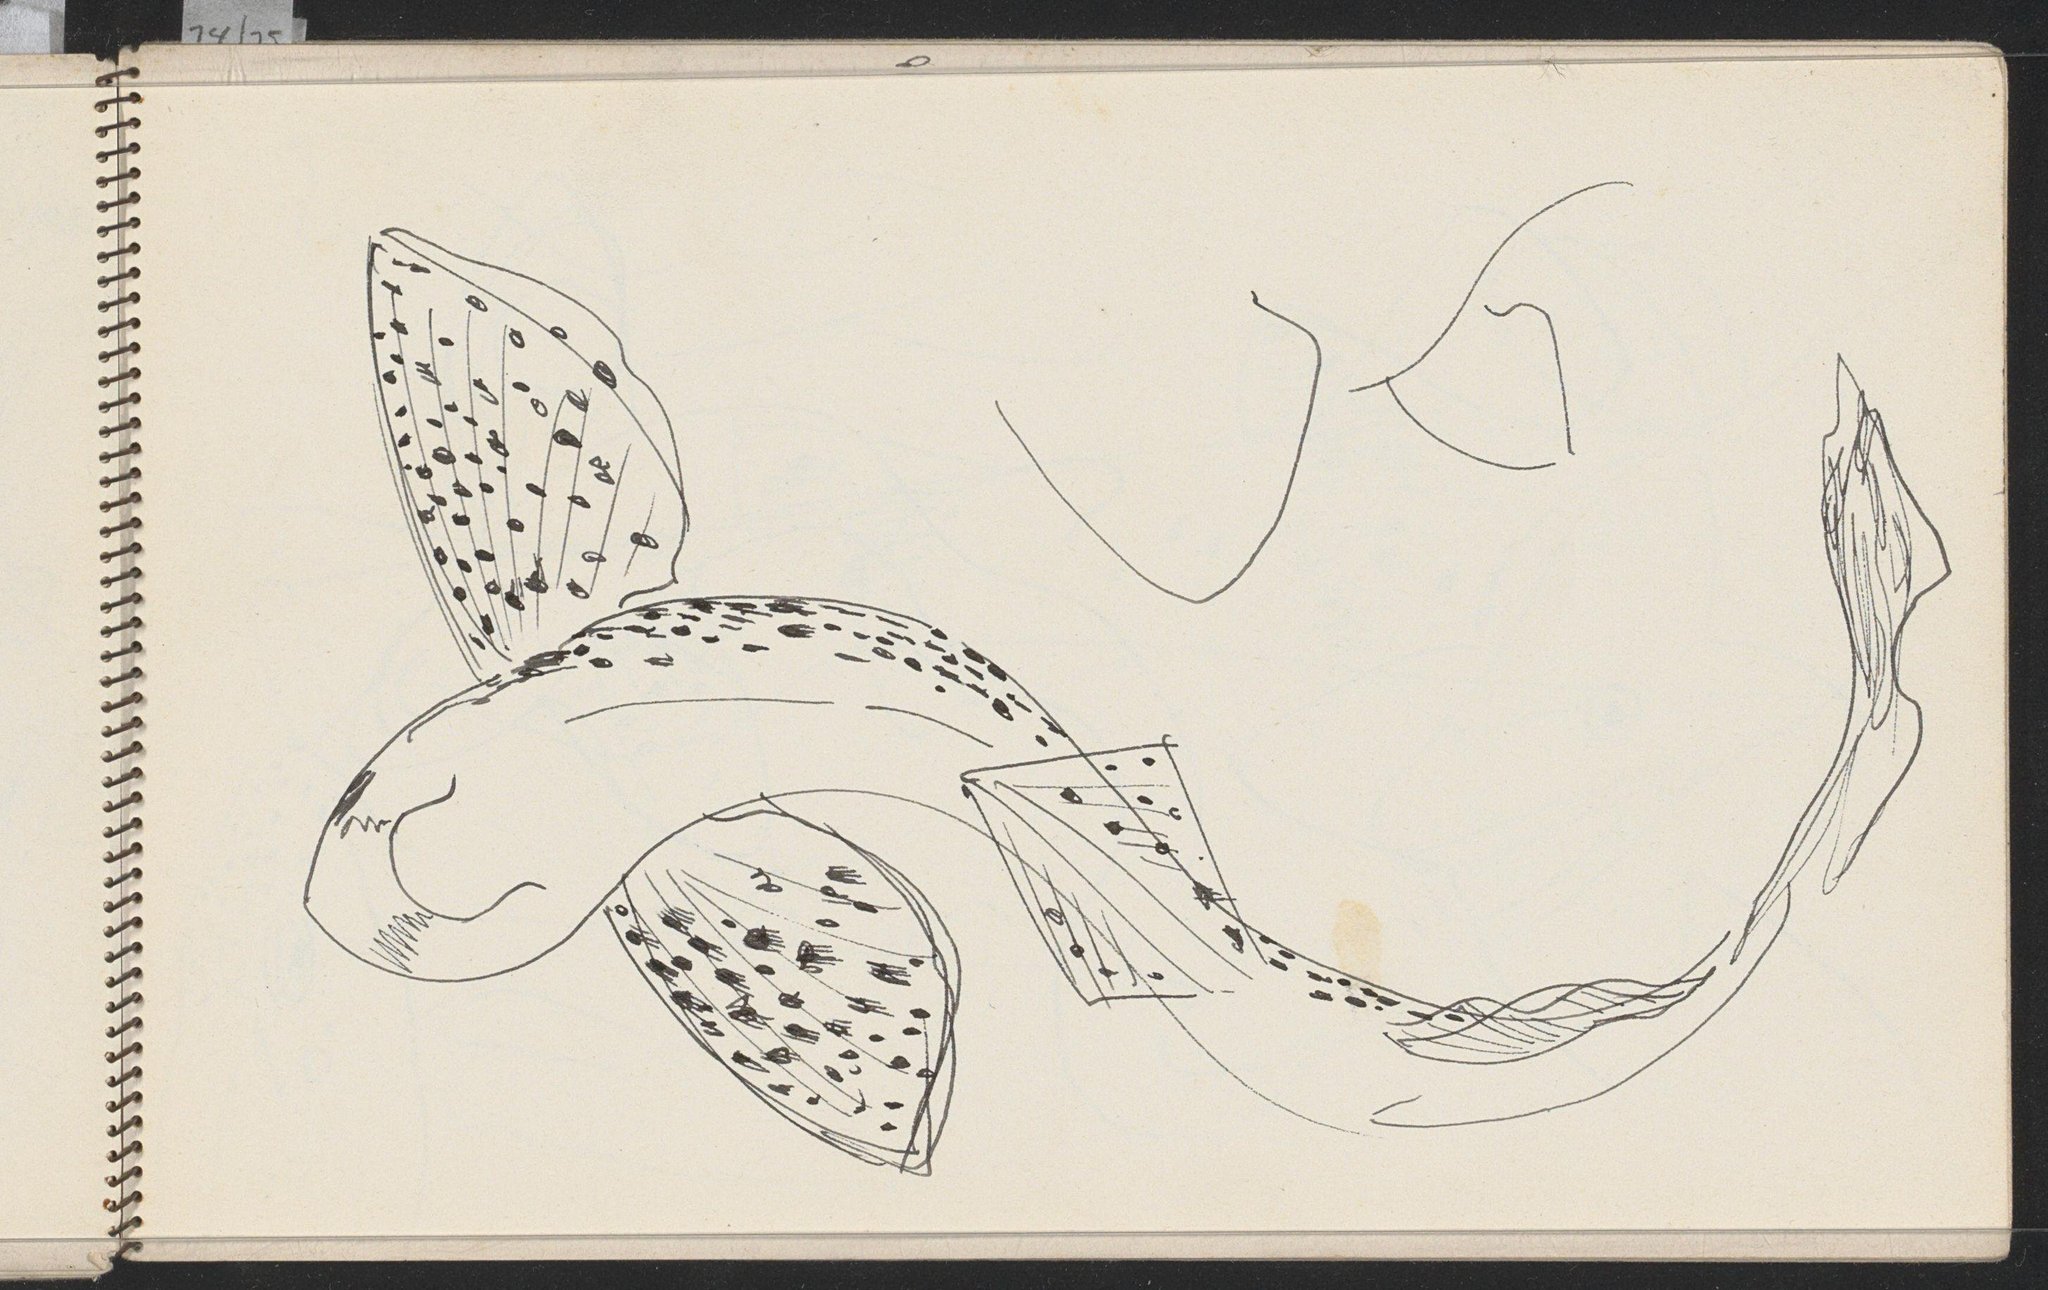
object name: sketchbook leaf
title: Vis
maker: carel adolph lion cachet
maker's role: draughtsman, print maker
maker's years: 1864-1945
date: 1930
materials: ink, paper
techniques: pen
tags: fishes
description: Blad 12 recto uit een schetsboek met 20 bladen.